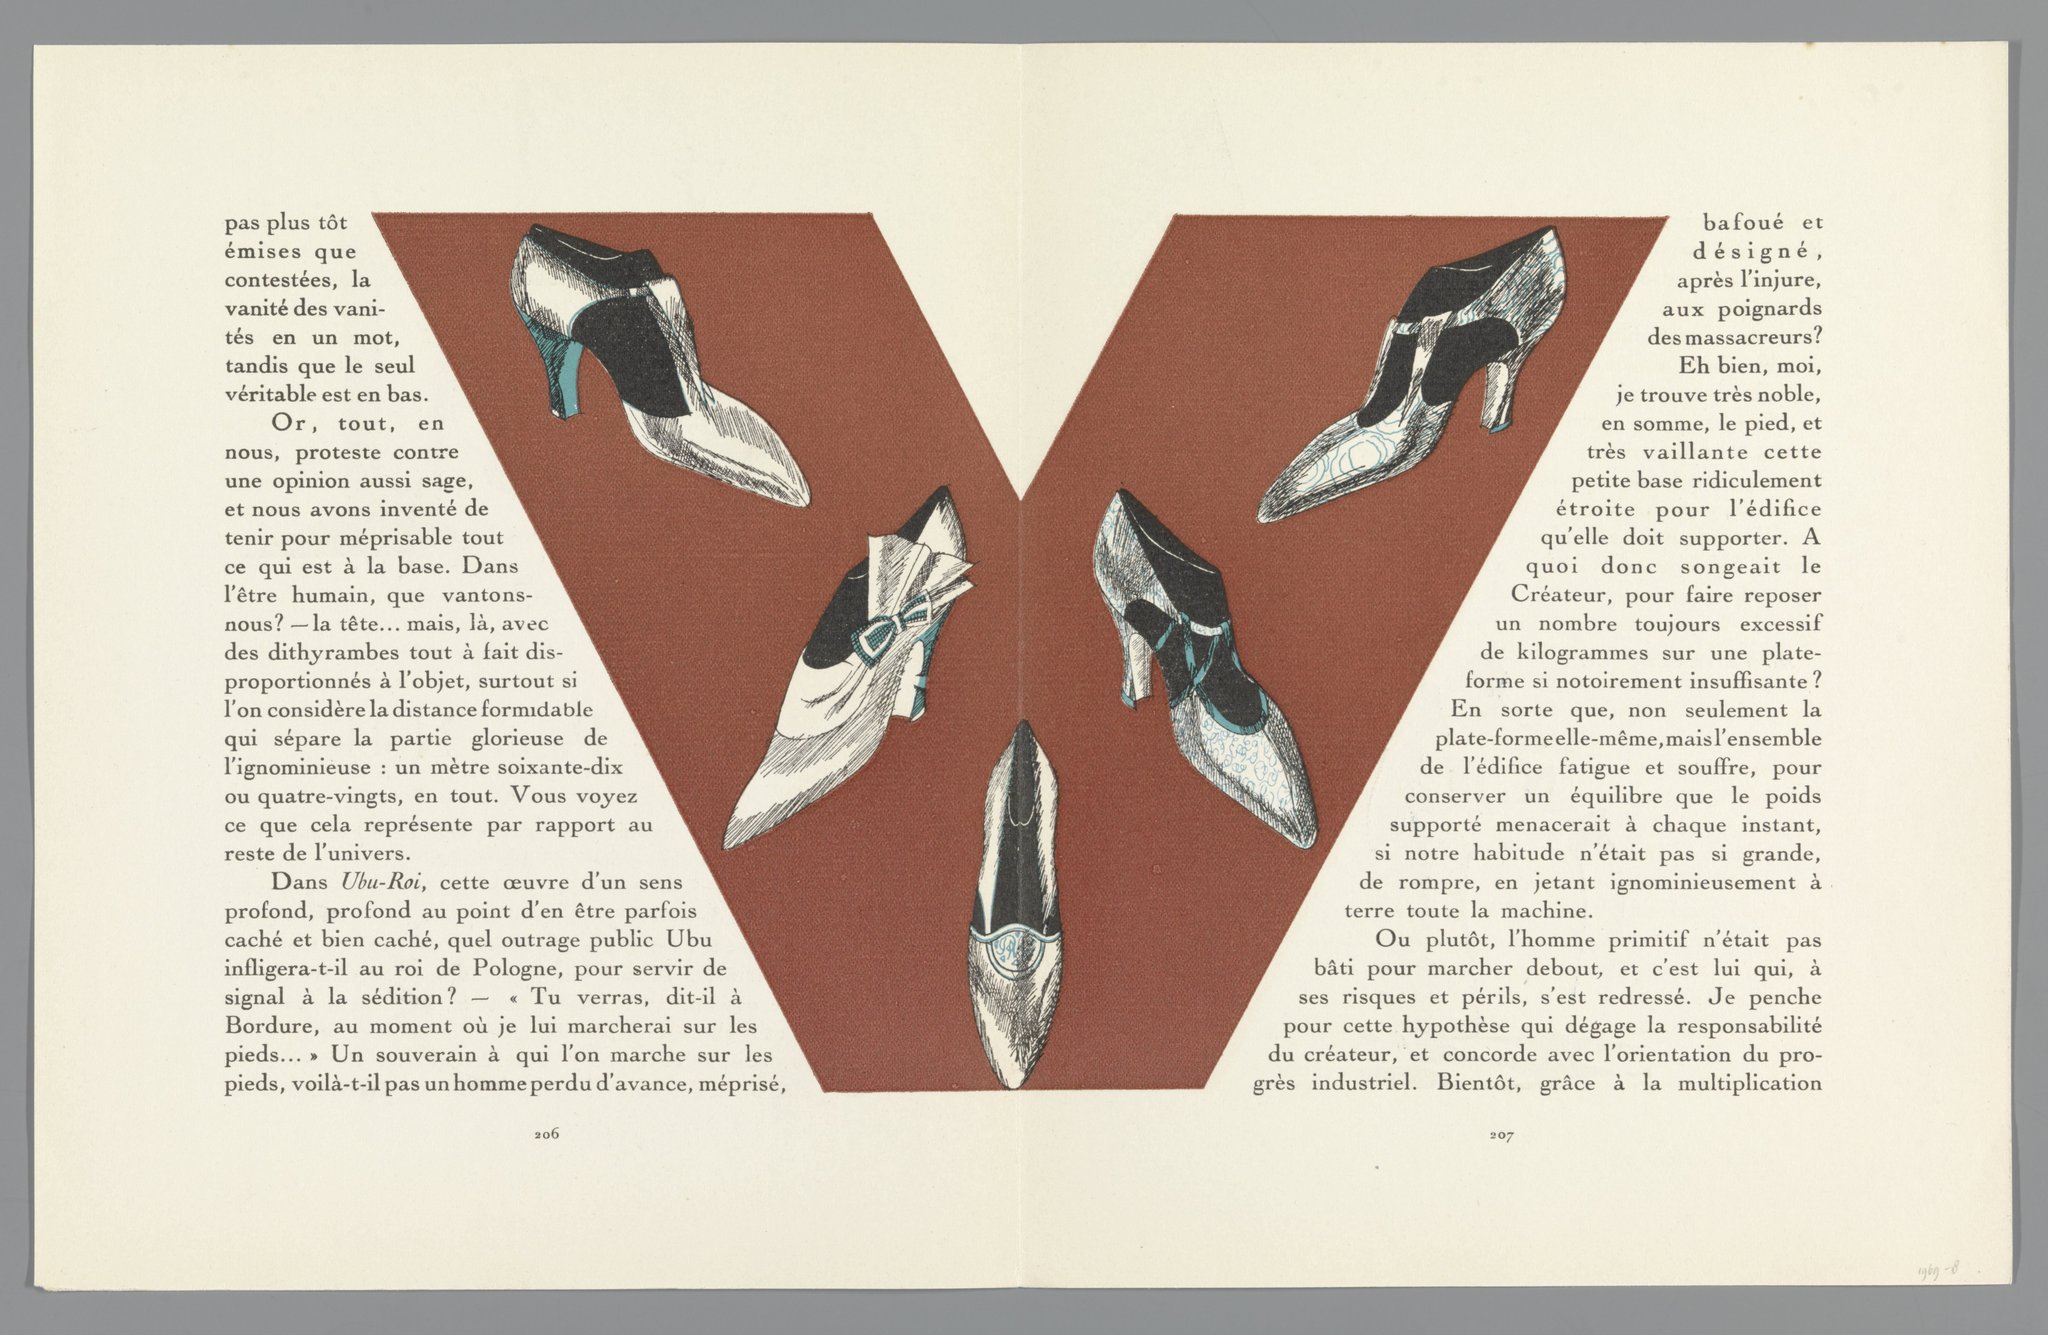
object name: print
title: Gazette du Bon Ton, 1923 - No. 5 : pp. 206-207: damesschoenen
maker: lucien vogel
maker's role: publisher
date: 1923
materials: paper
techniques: hand coloring, letterpress printing, photochemical processes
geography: paris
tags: fashion plates, shoes, sandals (+ women's clothes)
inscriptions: caption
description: Tekst en vijf damesschoenen van Perugia tegen donkerrood fond in V-vorm. Dubbele pagina in Gazette du Bon Ton 1923, No. 5.